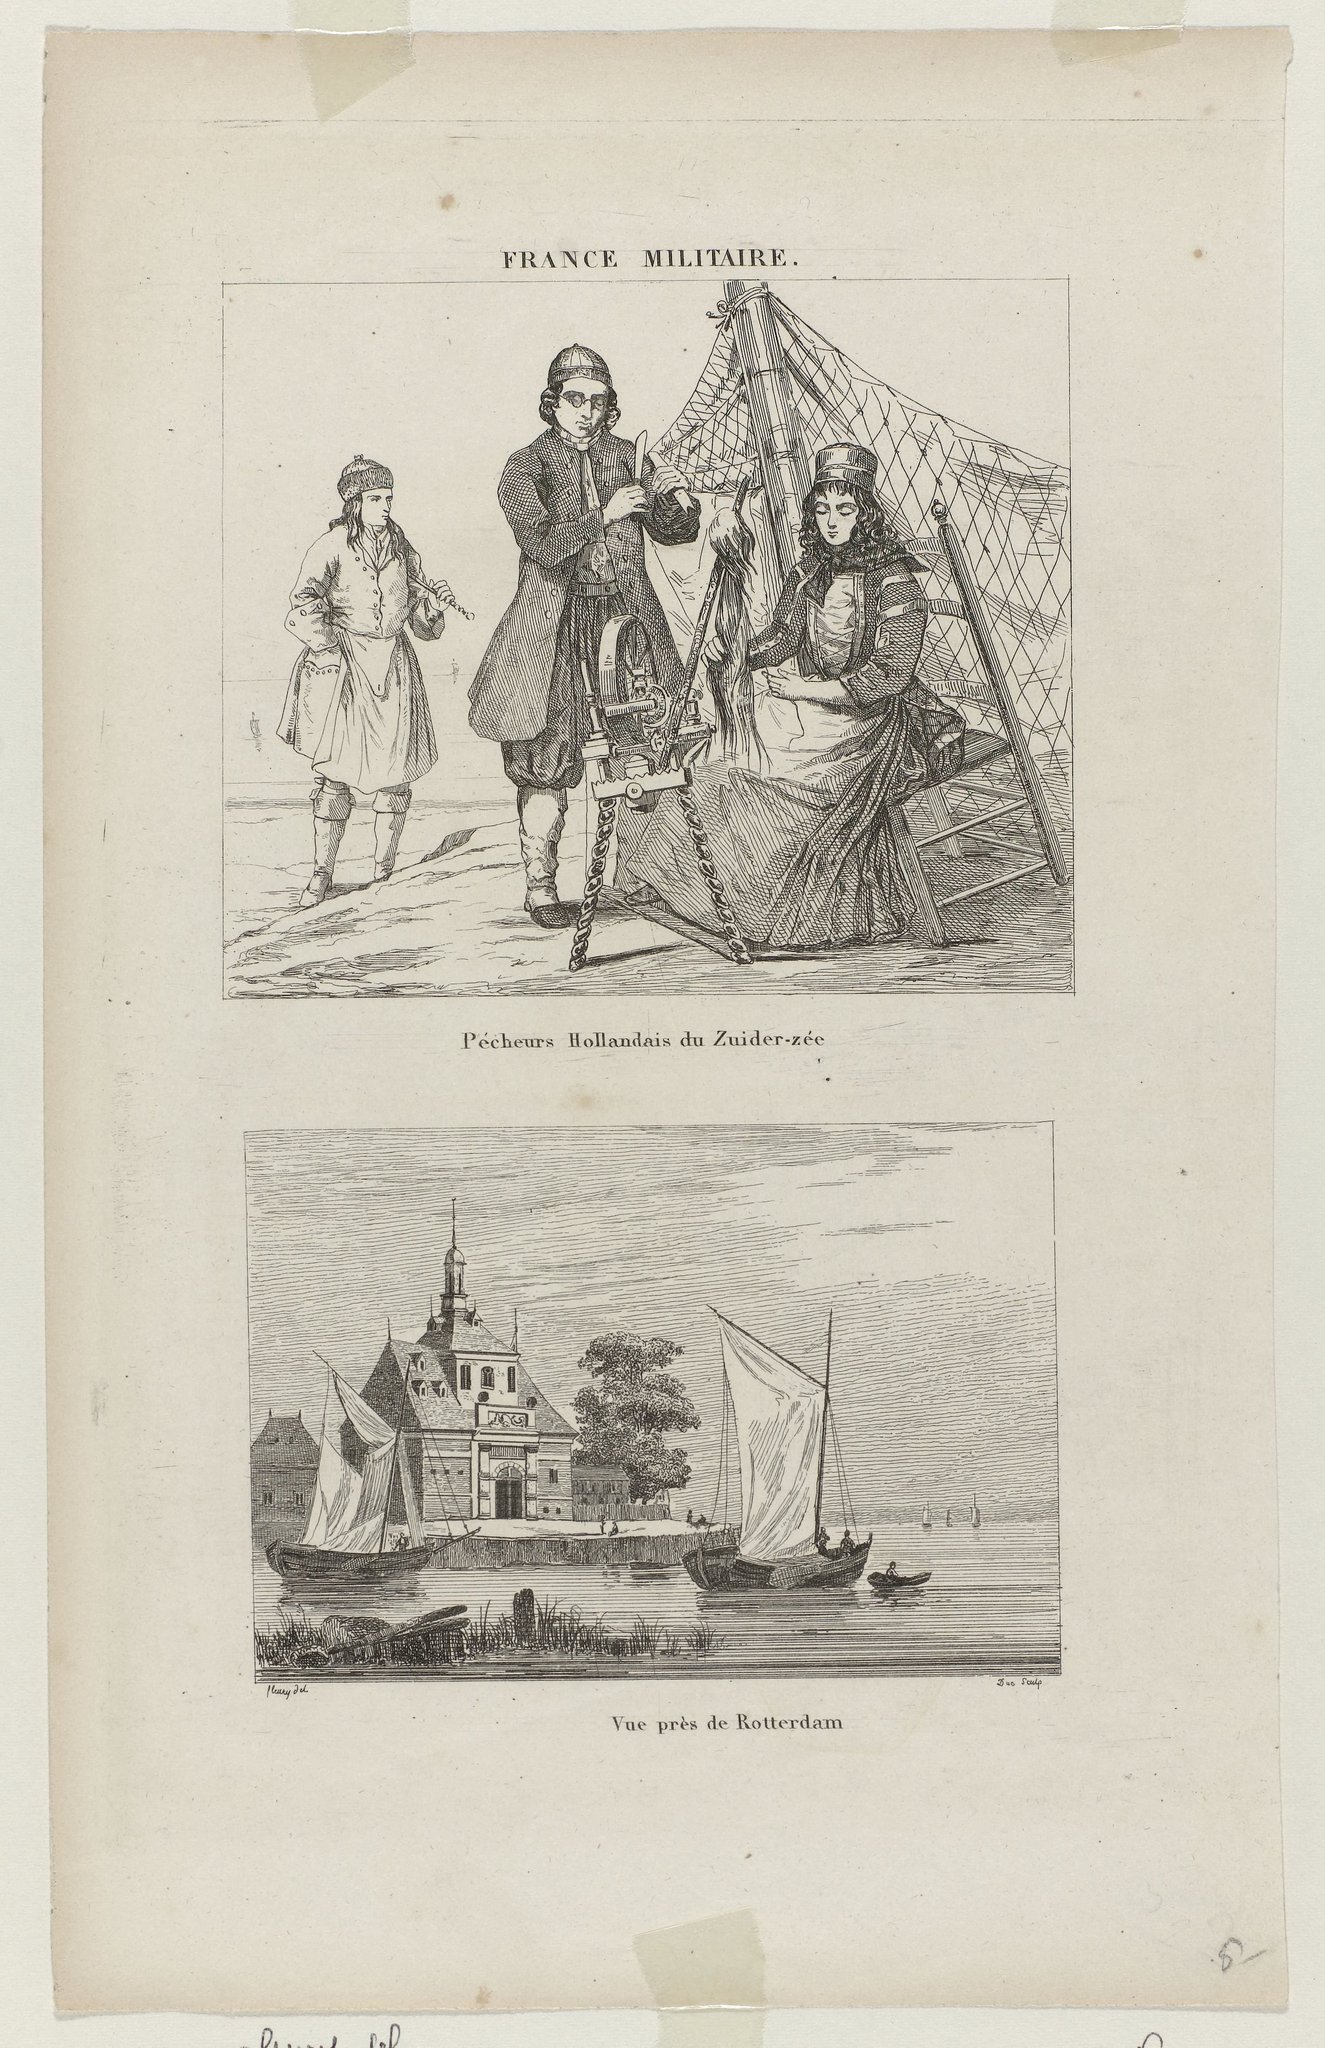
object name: print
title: France Militaire, Pecheurs Hollandais du Zuider-zée, 1853-1858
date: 1853-1858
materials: paper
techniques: etching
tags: landscapes with waters, waterscapes, seascapes (in the temperate zone), spinning-wheel, folk costume, regional costume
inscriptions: caption: ‘Pécheurs Hollandais du Zuider-zée / Vue près de Rotterdam’, title: ‘FRANCE MILITAIRE’